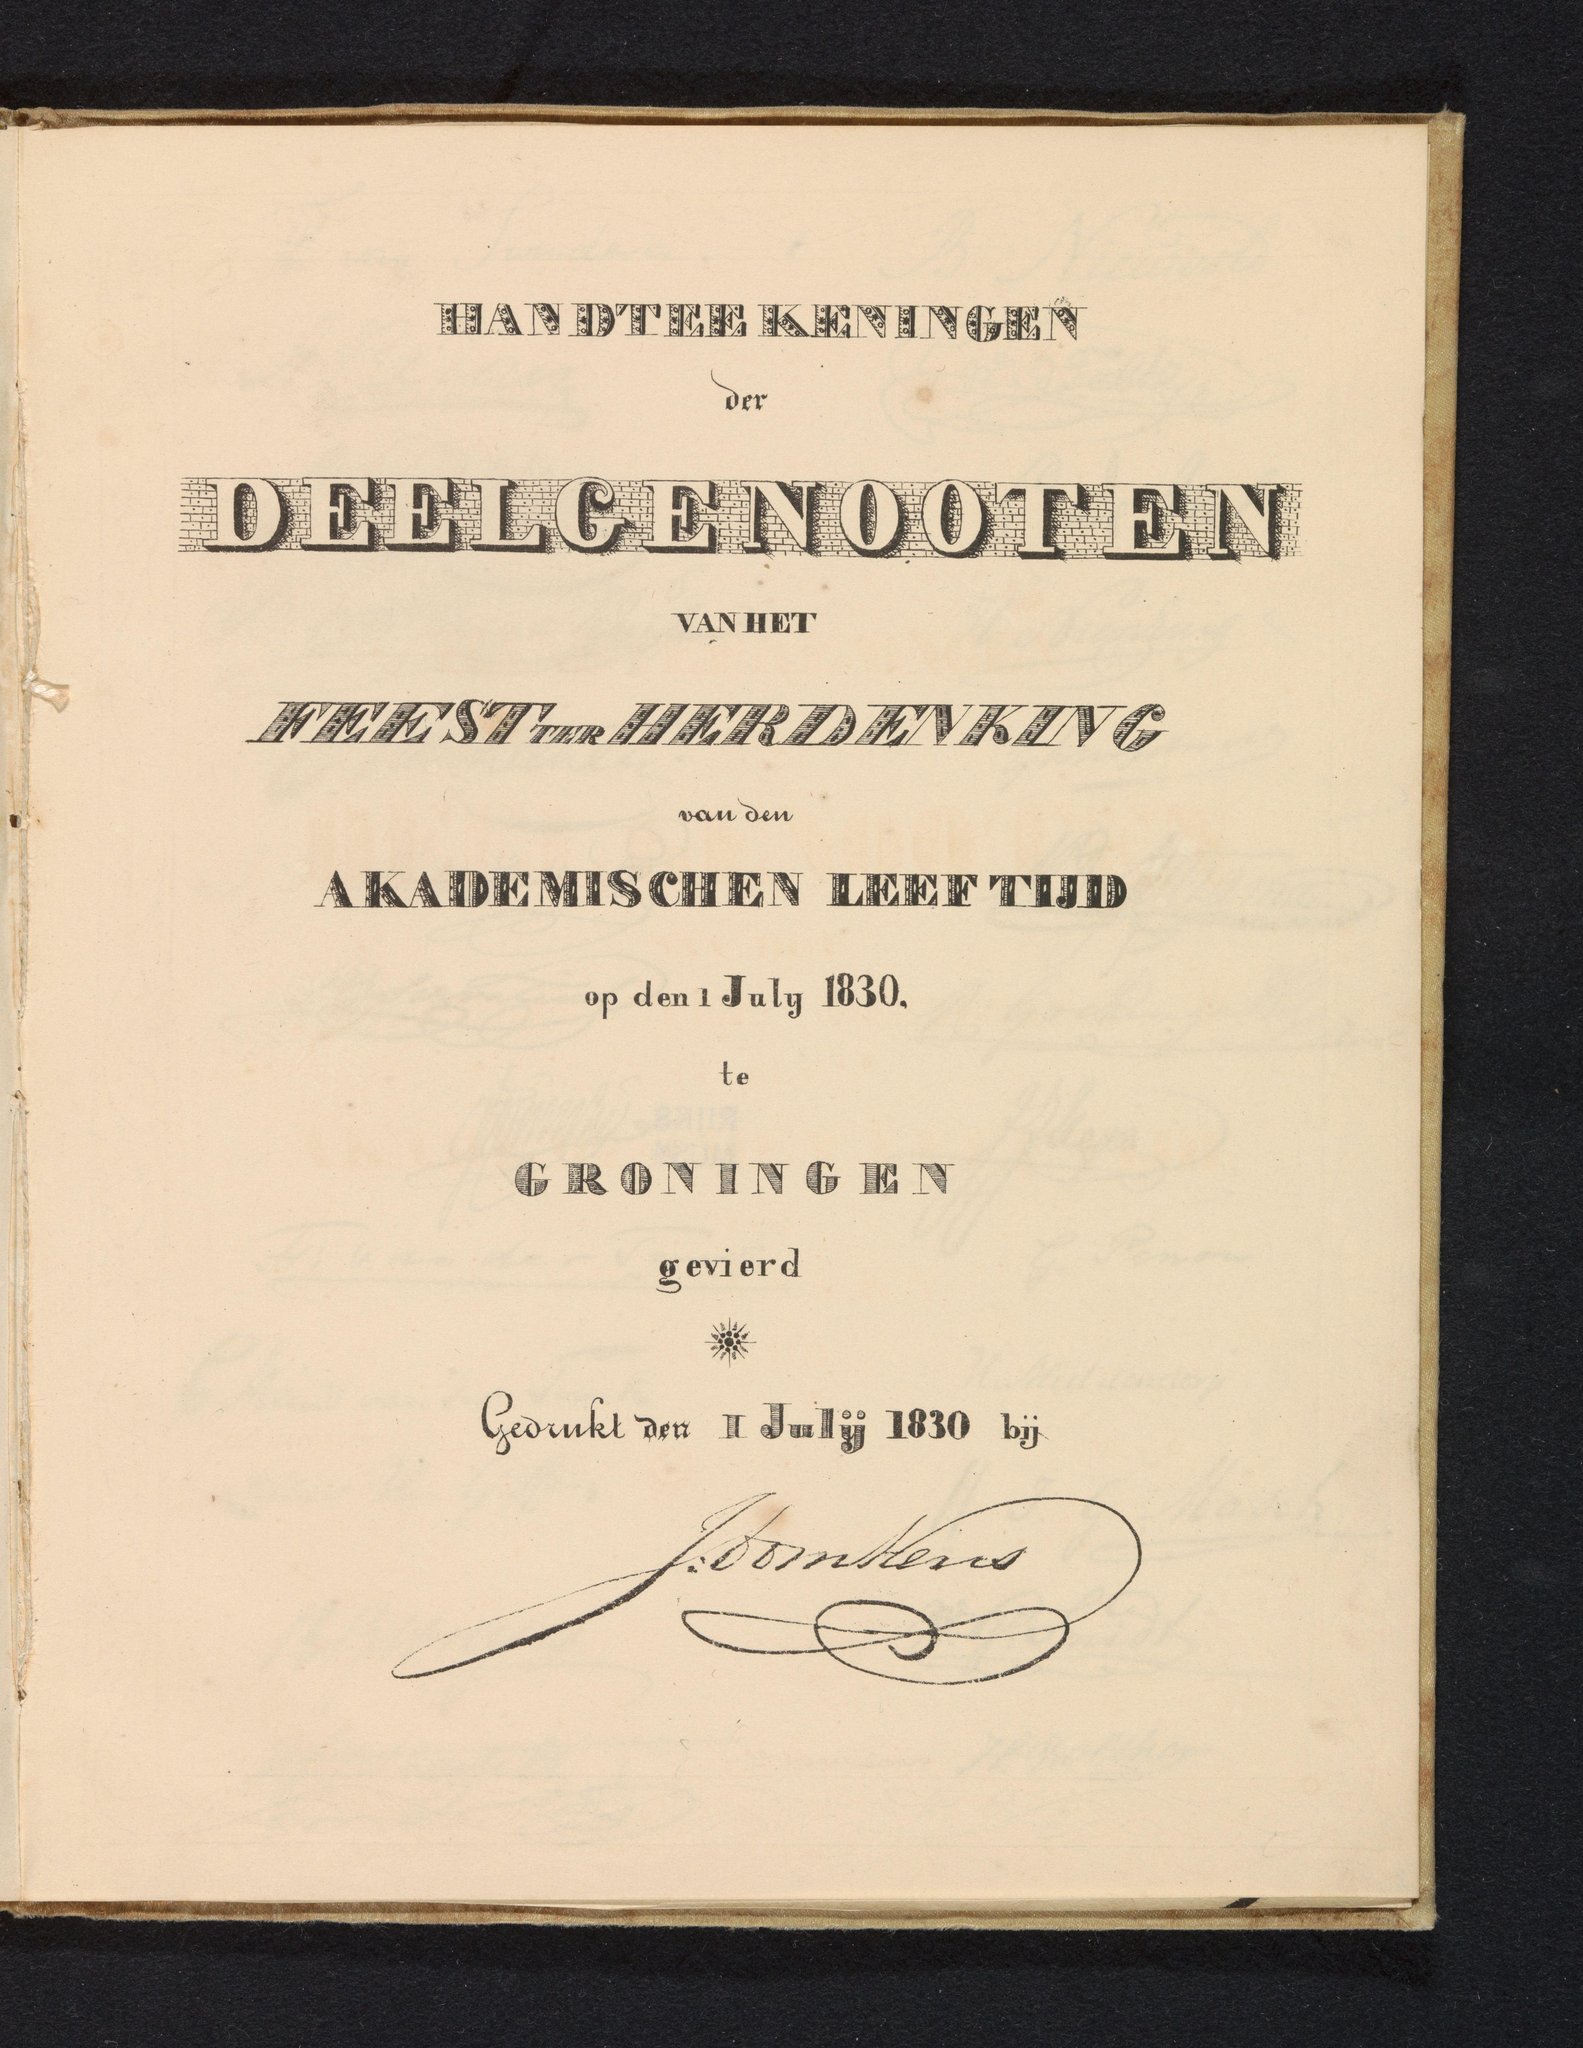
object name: print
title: Tweede titelblad, 1830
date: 1807-1830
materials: paper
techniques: lithograph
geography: groningen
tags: title-page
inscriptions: collector's mark: Lugt 2166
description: Tweede titelblad. Onderdeel van een boekje met de handtekeningen van de aanwezigen op het feest ter herdenking van de academische leeftijd op de Universiteit van Groningen op 1 juli 1830.